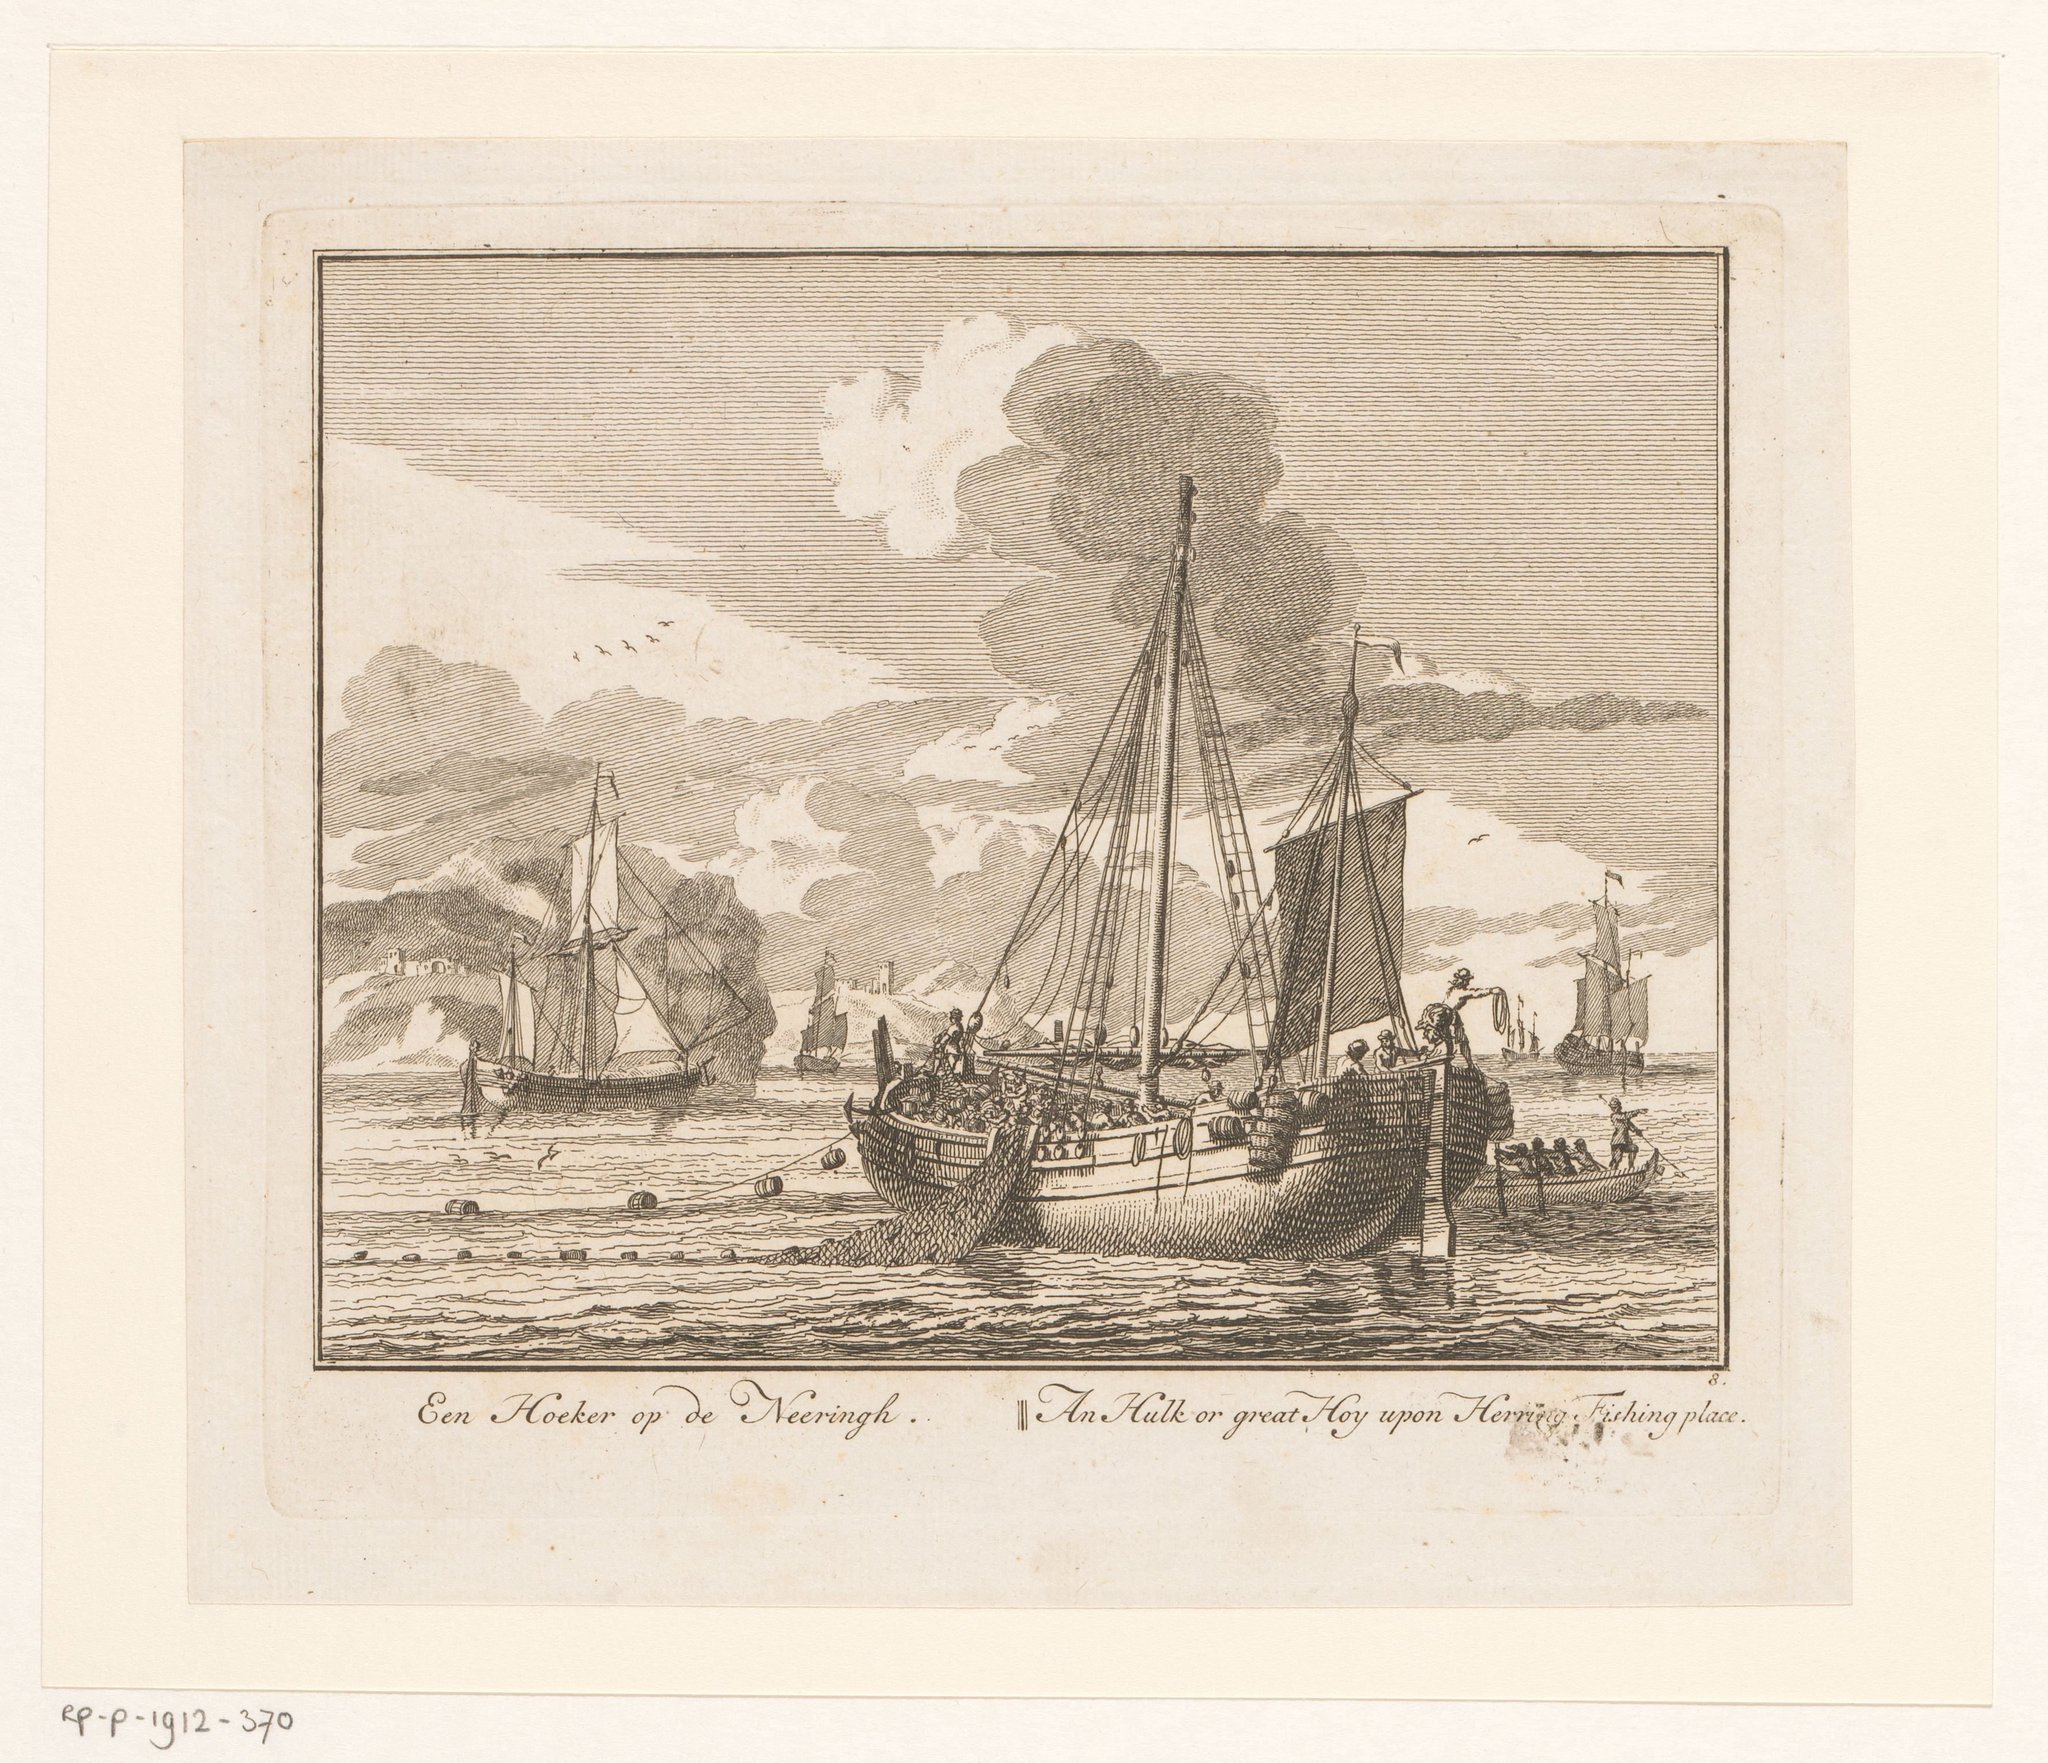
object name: print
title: Een Hoeker op de Neeringh / An Hulk or great Hoy upon Herring Fishing place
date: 1728-1761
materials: paper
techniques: etching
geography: amsterdam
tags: bony fishes: herring, sea and coastal fishery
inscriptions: collector's mark: Lugt 2228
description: Muller beschrijft onder FMH 3013C een ander volledig exemplaar van de serie bestaande uit 32 platen. In dit album zijn slechts 17 prenten uit de serie aanwezig (nrs 1-17).